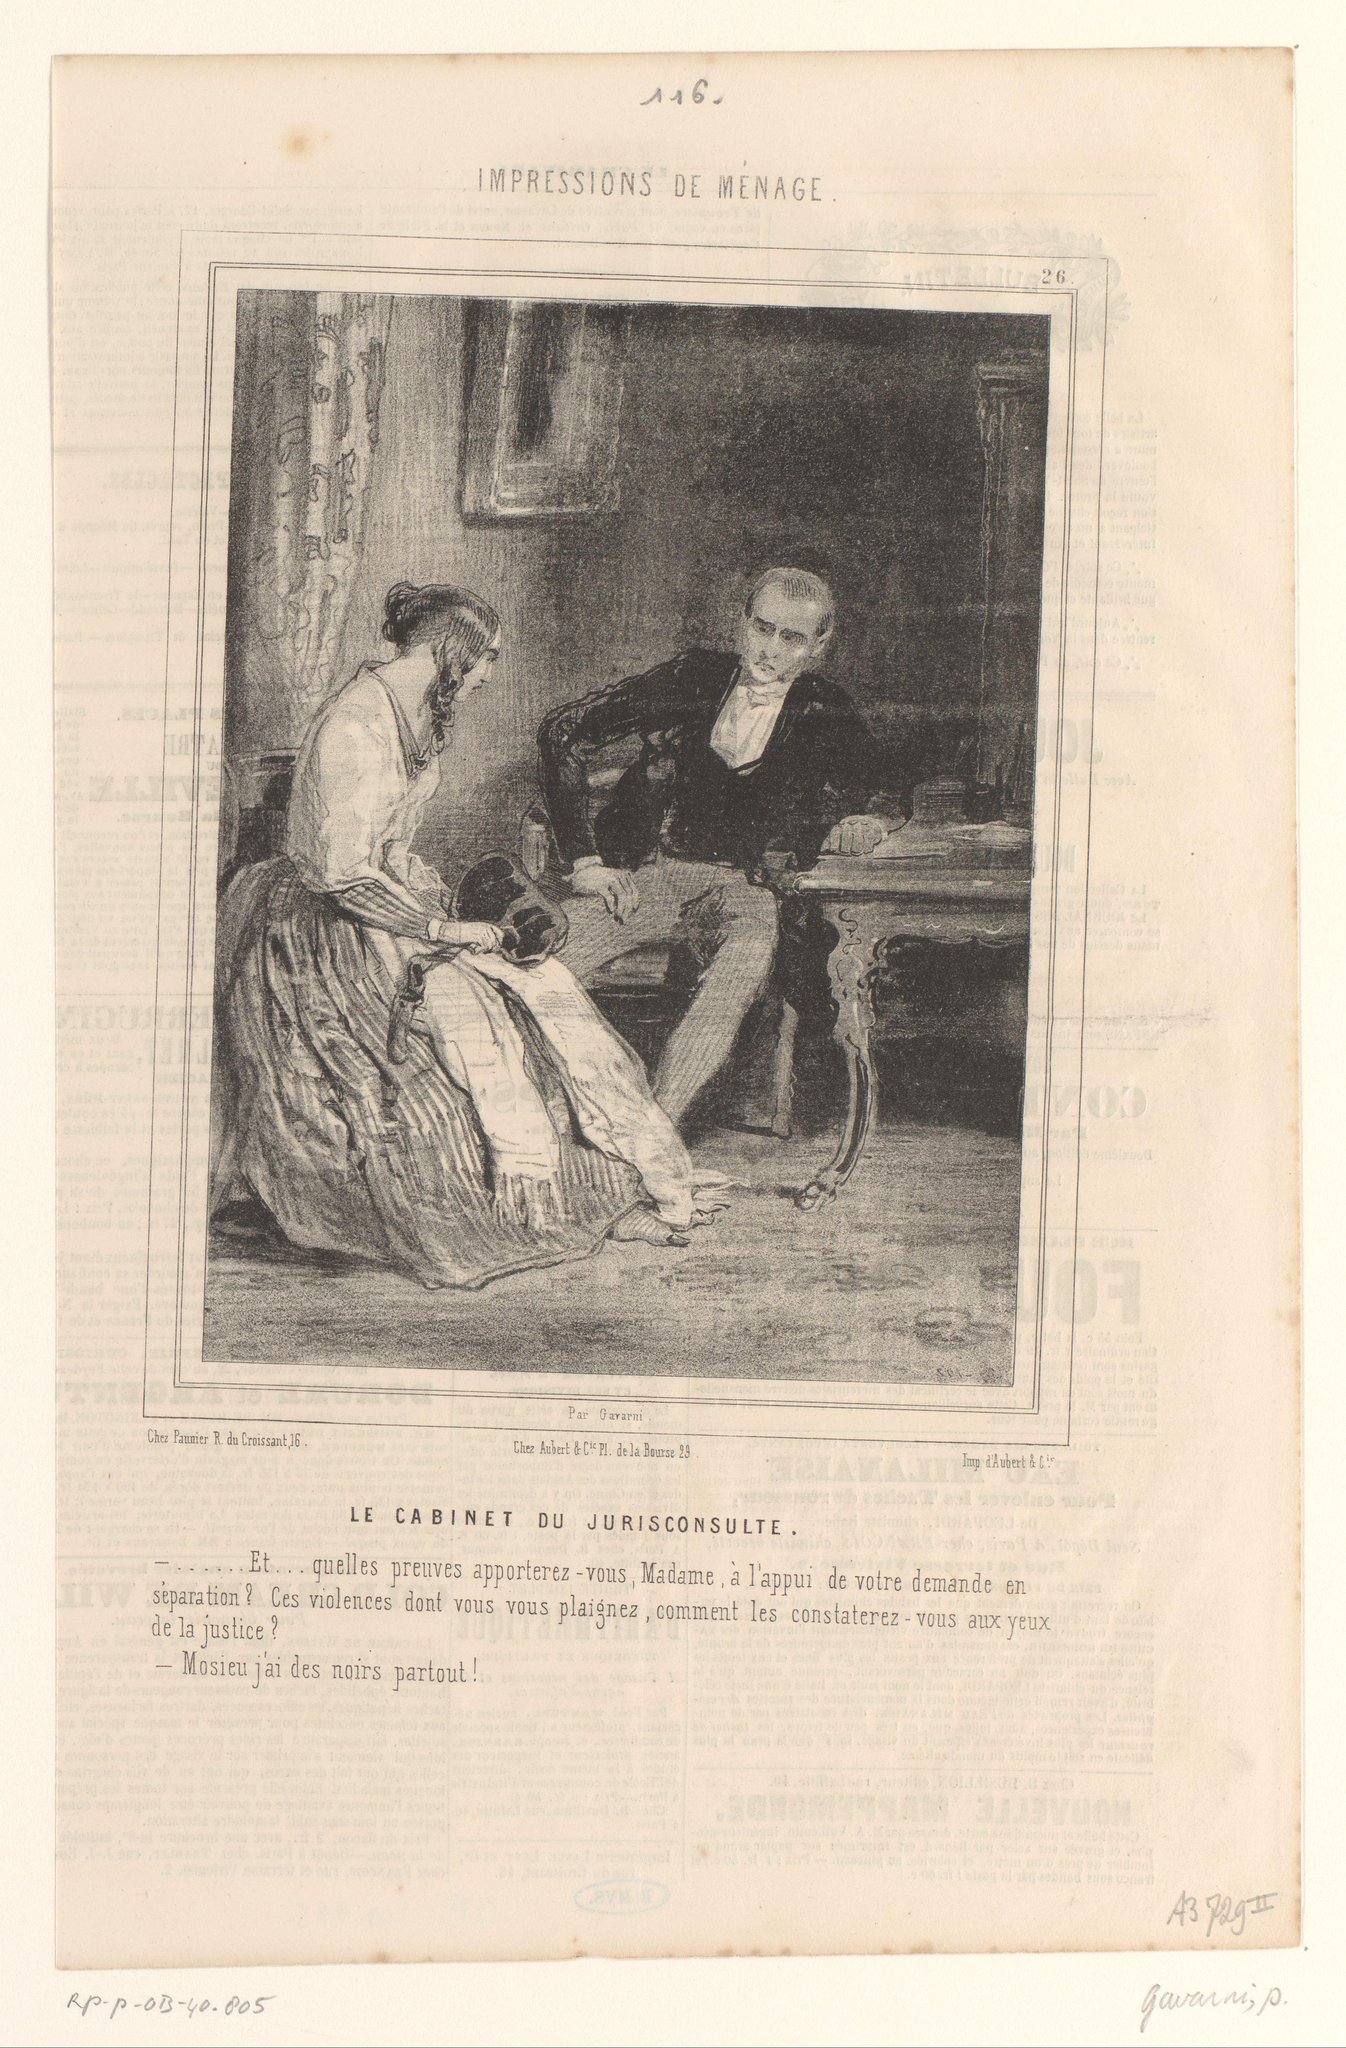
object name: cartoon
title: Impressions de ménage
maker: paul gavarni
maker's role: draughtsman, print maker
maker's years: 1804-1866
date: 1843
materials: paper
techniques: lithograph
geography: paris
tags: divorce, bad husband, lawyer, attorney at law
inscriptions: collector's mark: Lugt 2228a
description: Prent gebruikt voor: Le Charivari, 10 oktober 1843.